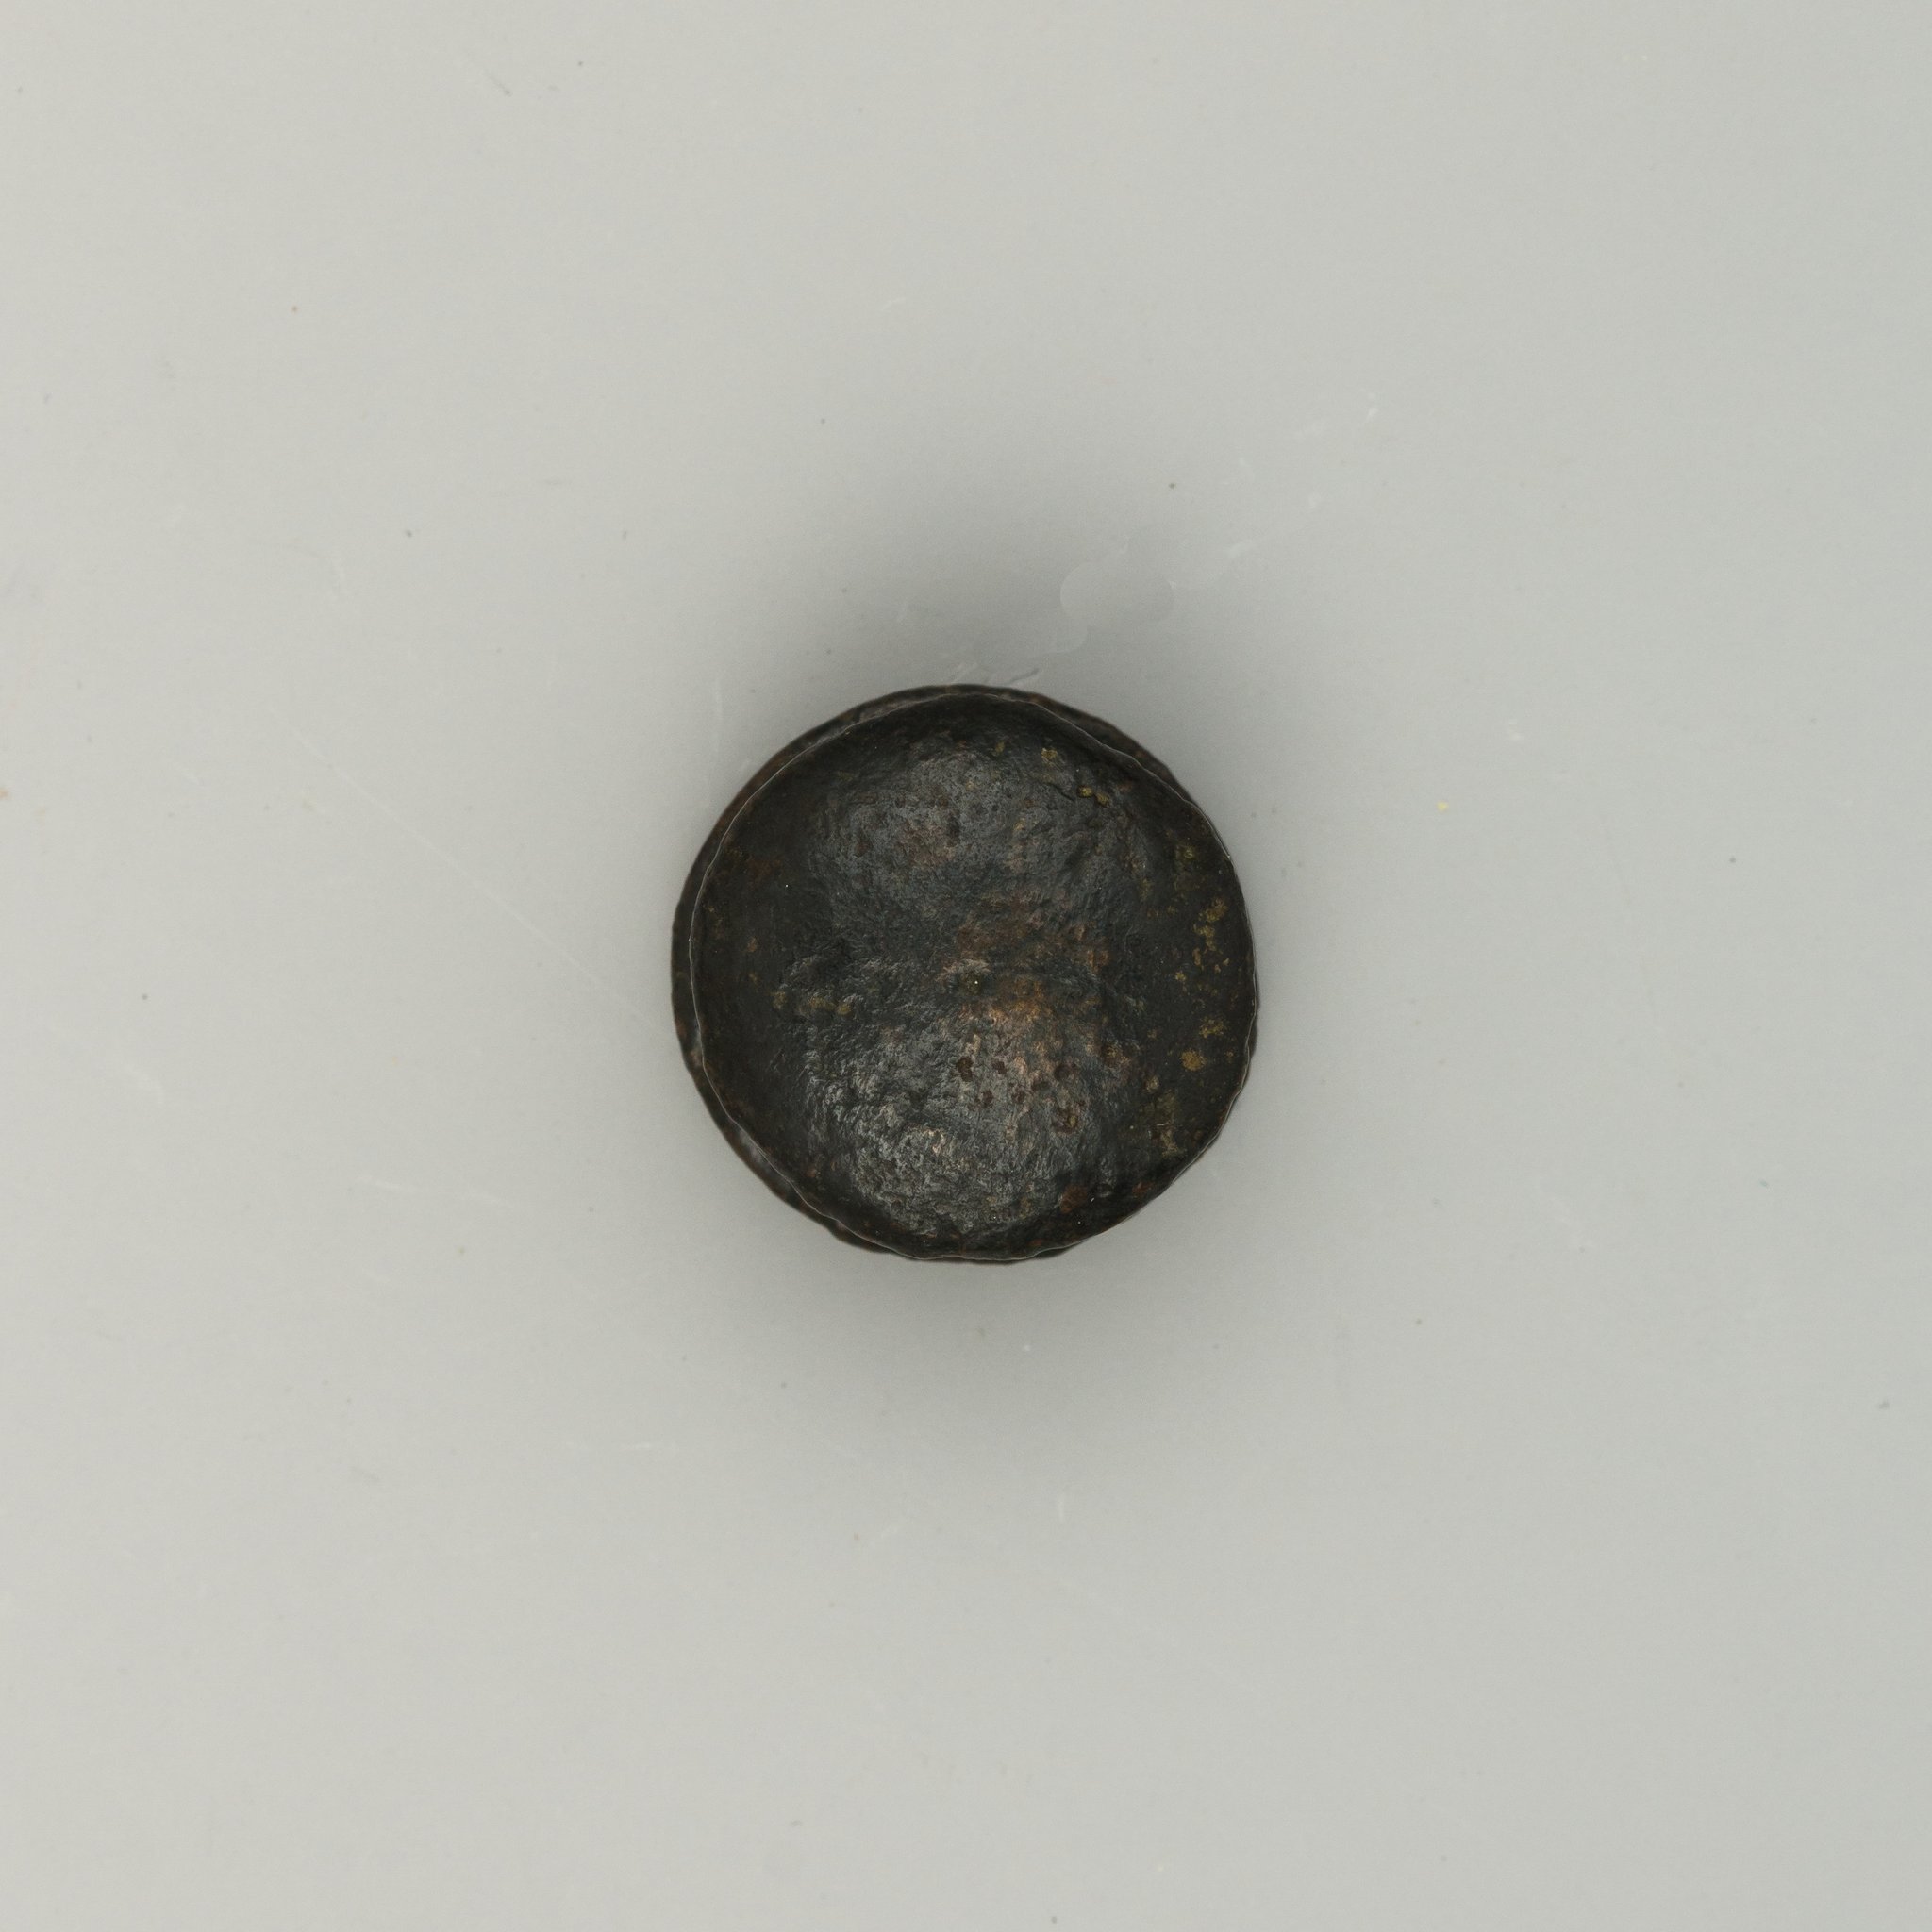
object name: button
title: Button, maybe for a Horse Tack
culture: roman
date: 1-400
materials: copper alloy